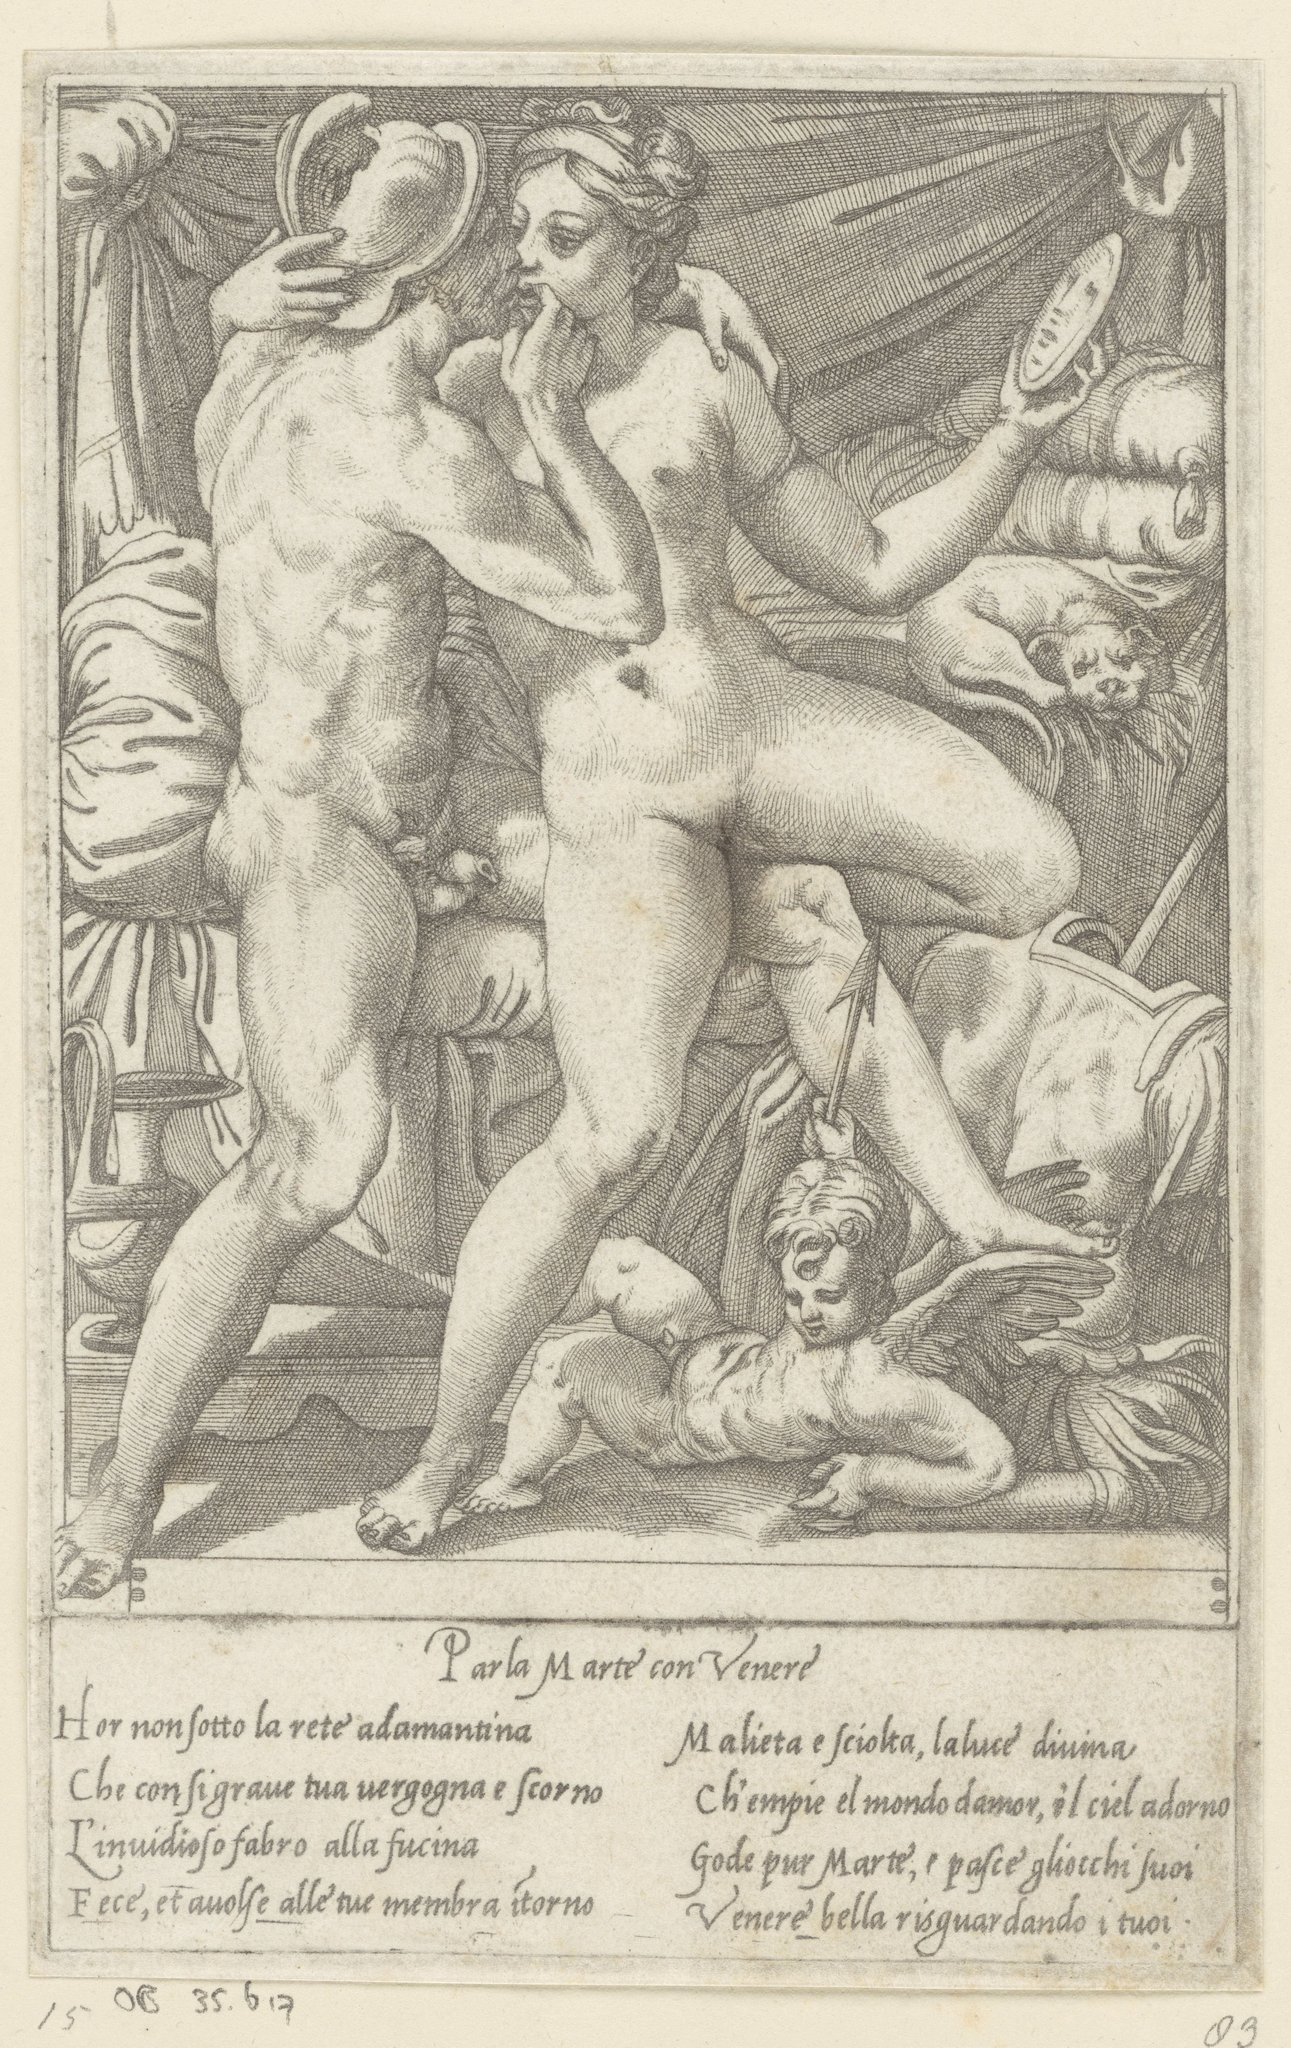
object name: print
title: Loves of the Gods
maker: giovanni jacopo caraglio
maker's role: goldsmith, print maker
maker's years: 1500-1565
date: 1515-1565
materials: paper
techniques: engraving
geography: italy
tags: mars and venus as lovers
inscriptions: collector's mark: Lugt 240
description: No collection of erotic prints should be without Caraglio’s Loves of the Gods. Consisting of twenty-some prints, this scandalous series presents the amorous escapades of the classical gods fairly explicitly. The deities give in to pure lust with great abandon, which involves quite some acrobatic feats. These scenes will doubtless have titillated many a viewer.